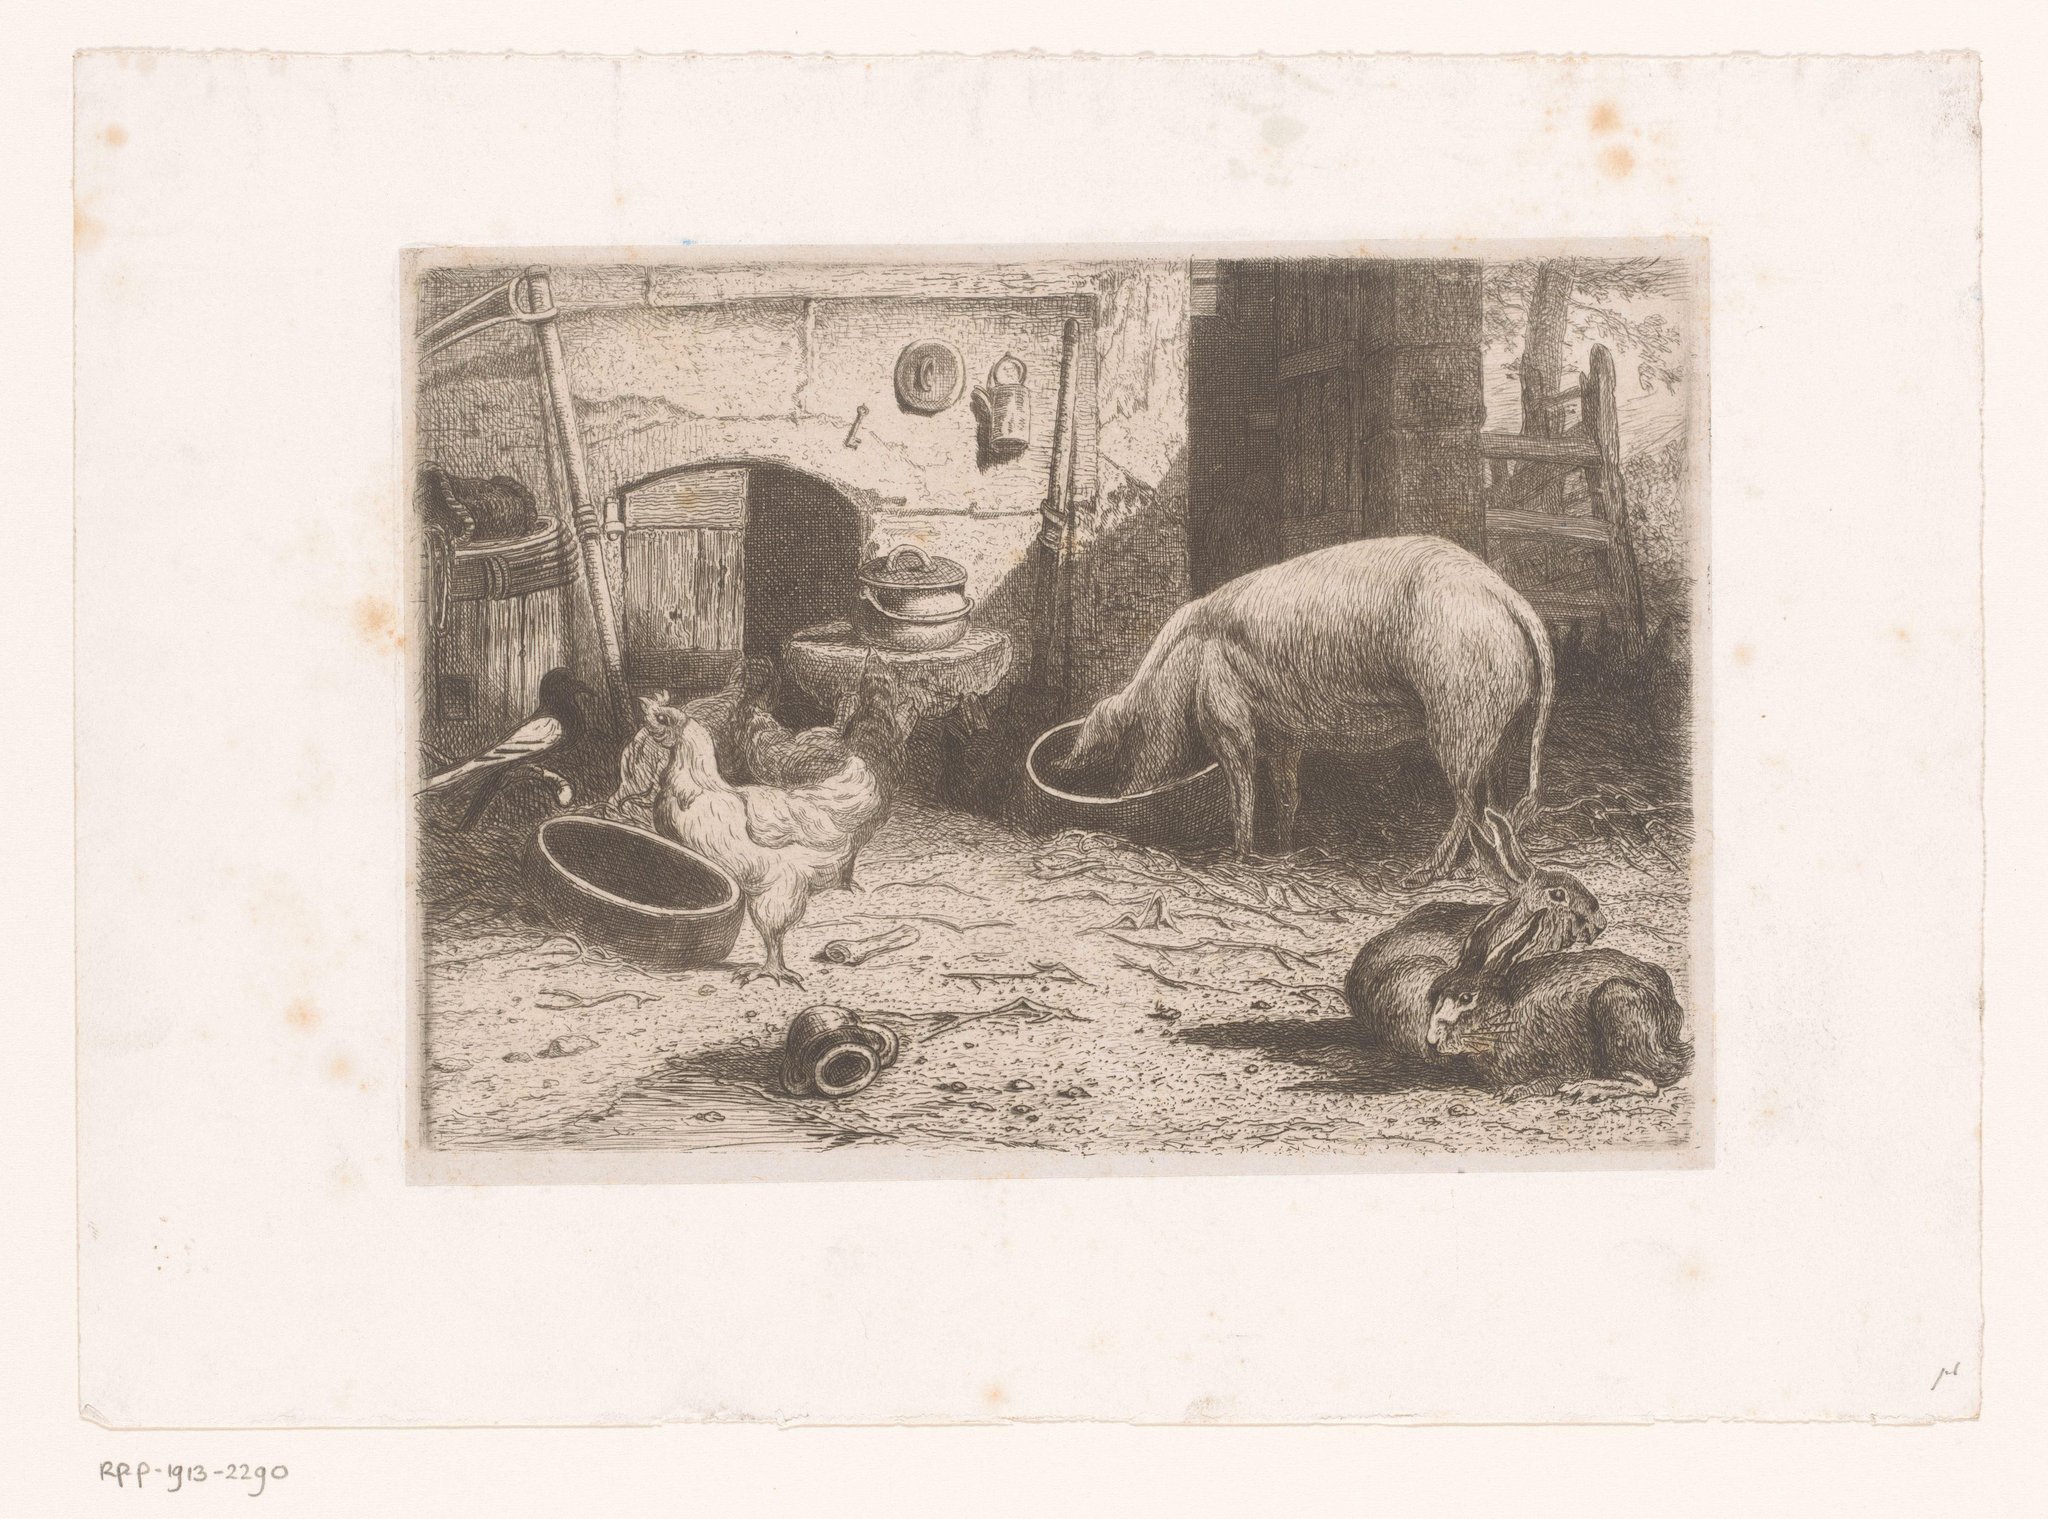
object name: print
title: Varken, kippen en konijnen bij een schuur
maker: auguste numans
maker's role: print maker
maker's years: 1823-1883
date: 1833-1879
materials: paper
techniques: etching, intaglio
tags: barn, pig, fowl (cock, hen, chicken, etc.), rodents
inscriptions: collector's mark: Lugt 2228